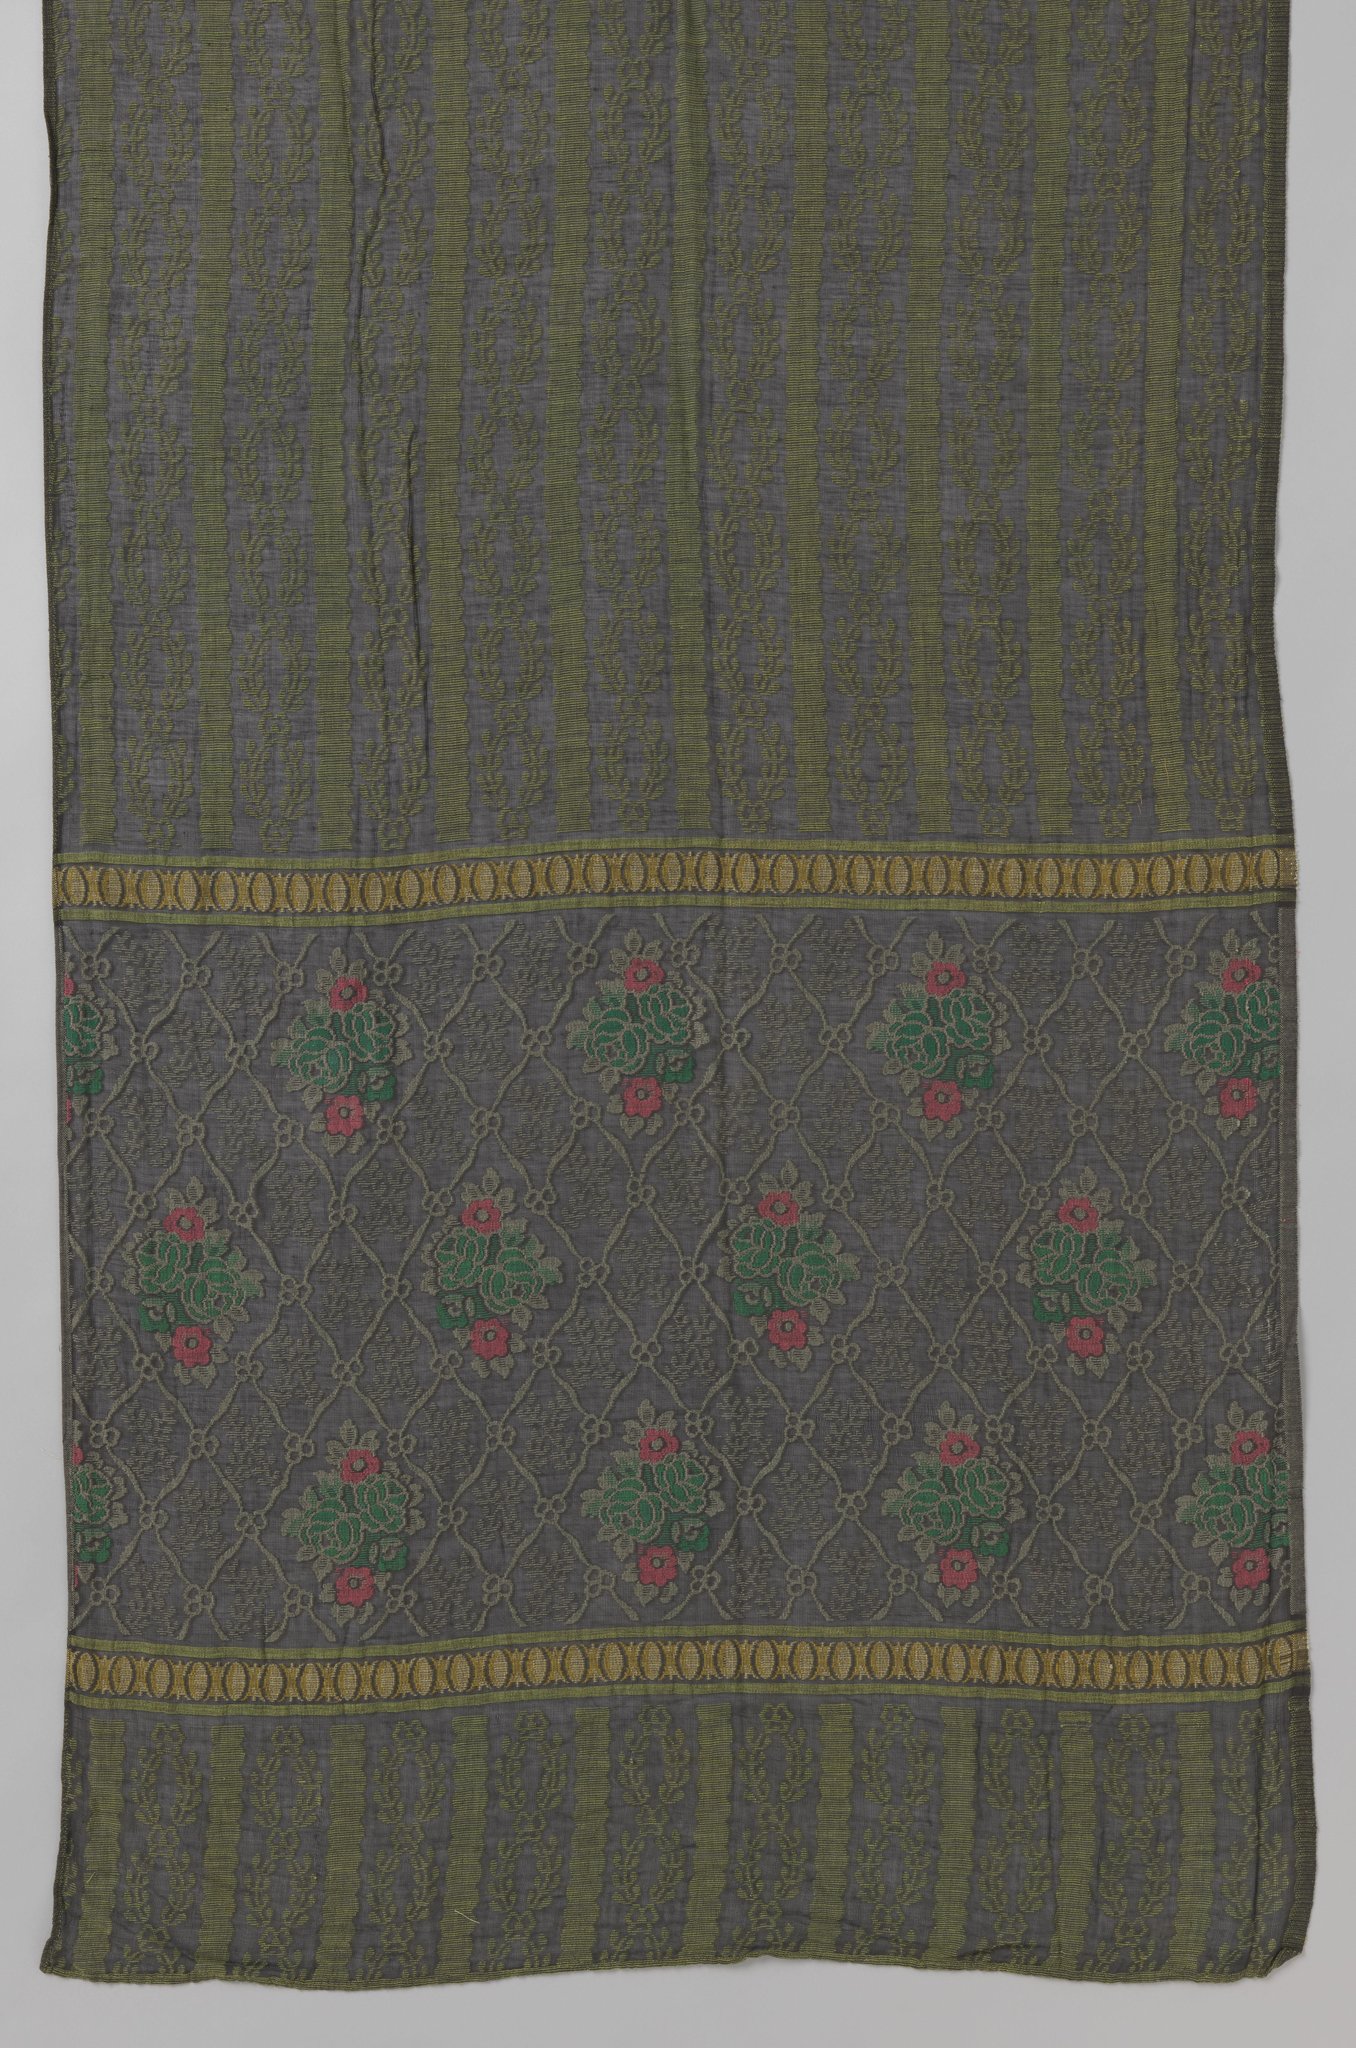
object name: curtain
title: Gordijn voor een serre in zwart gaasweefsel, patroon "Madras".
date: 1920-1930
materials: textile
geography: ghent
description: Gordijn voor een serre van madras in zwart gaasweefsel met groene verticale strepen en bladranken in ovaalvorm. Onderaan afboording in zelfde motief. Binnen een lijstornament een brede en een smalle strook groene rozen en rose bloemen tussen een ruitvormig patroon met bladranken in. Bovenaan tien ophangringen bevestigd.